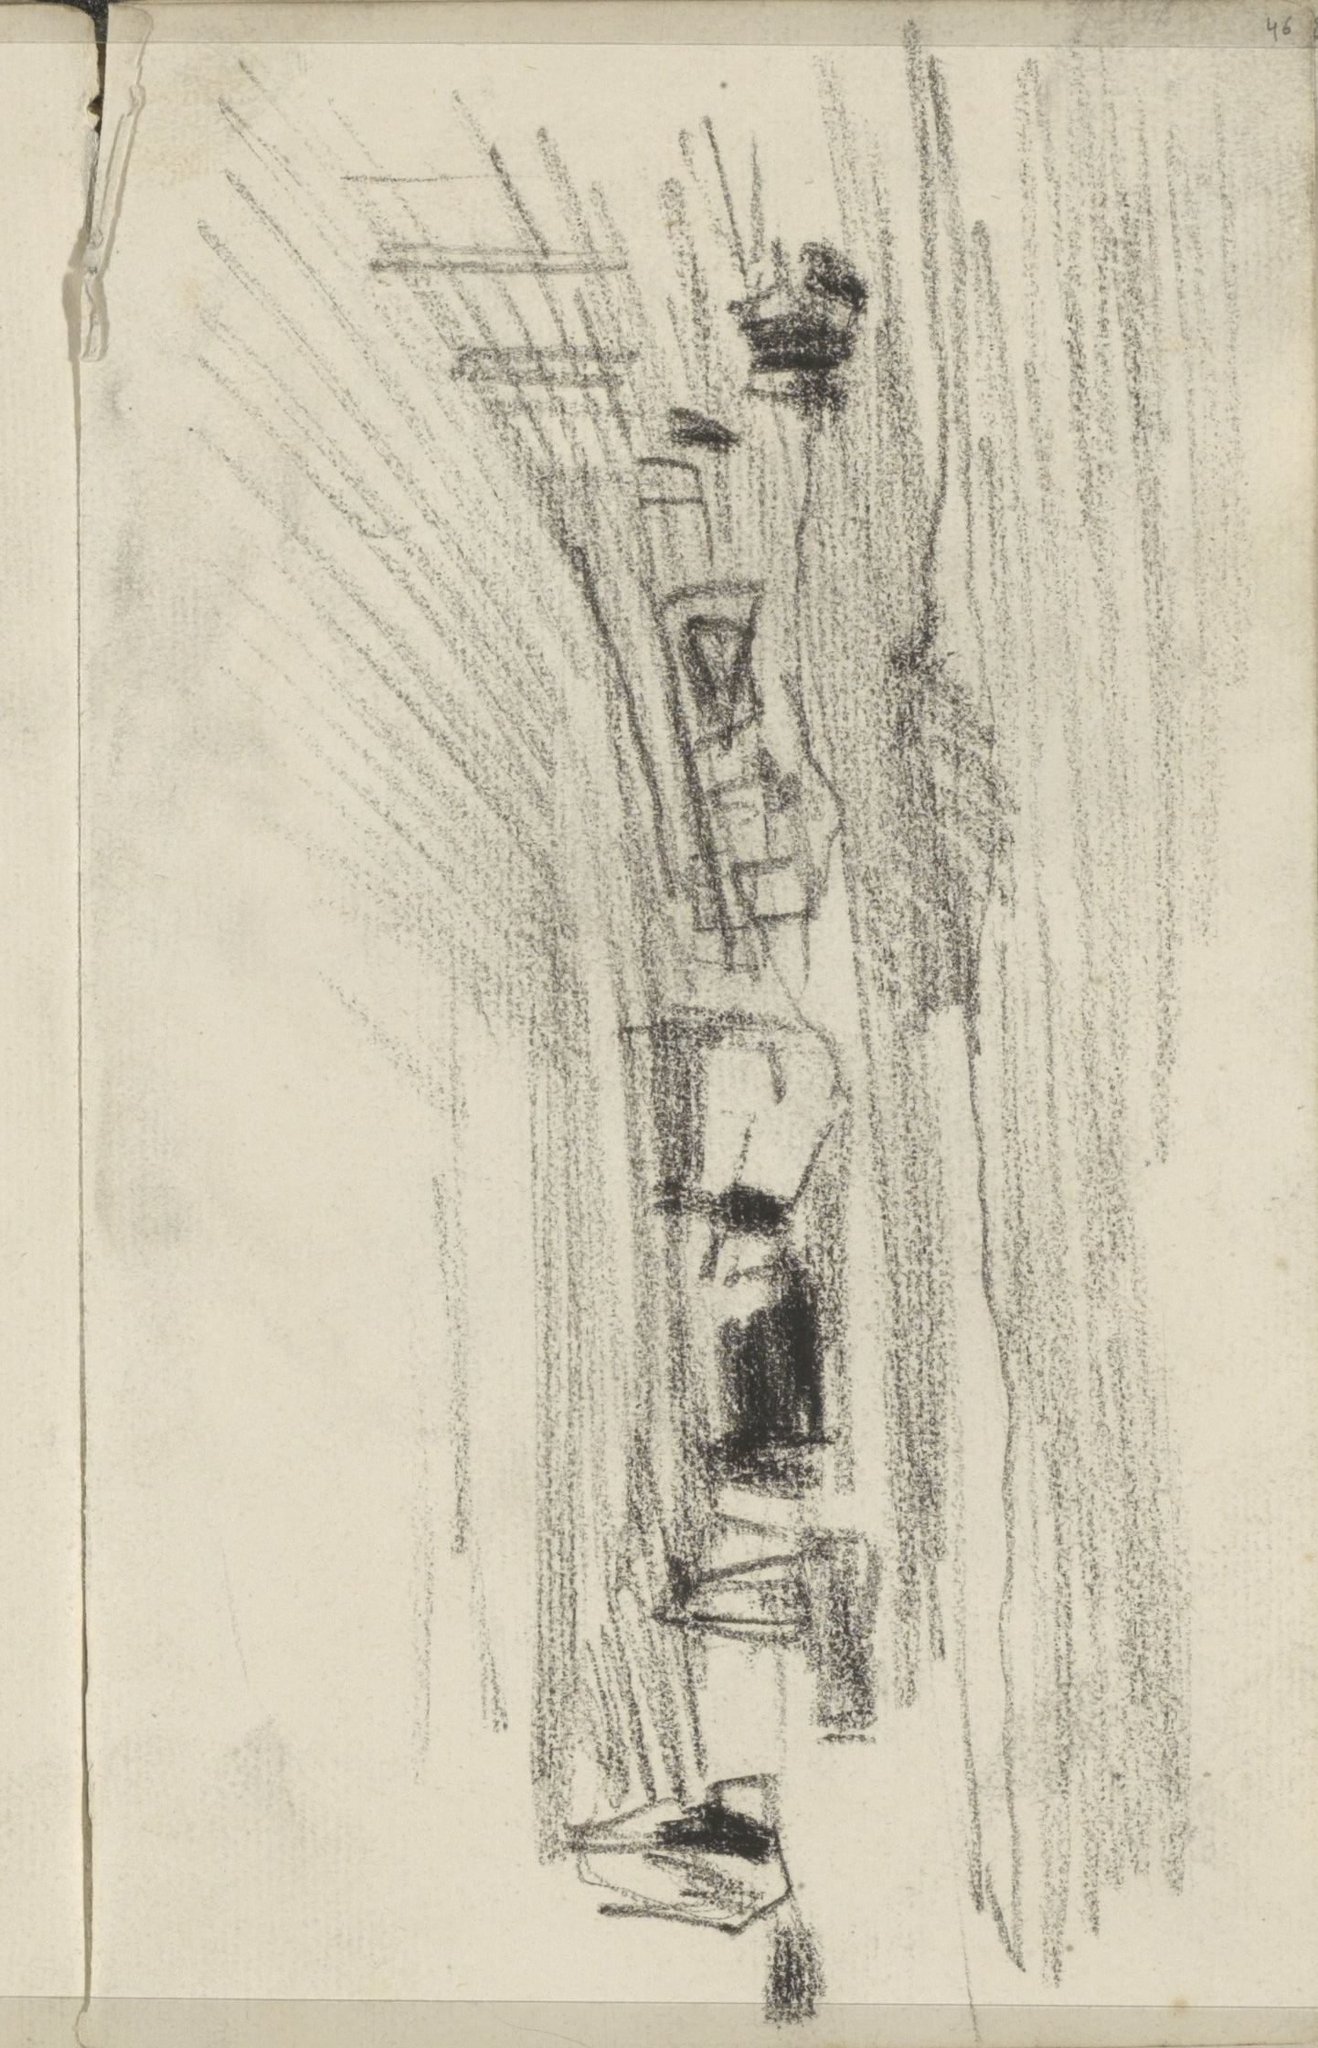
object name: sketchbook leaf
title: Koeien in een wei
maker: george hendrik breitner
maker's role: draughtsman, painter, print maker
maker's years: 1857-1923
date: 1884-1886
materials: chalk, paper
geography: the hague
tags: cow, meadow, pasture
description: Pagina 46 uit een schetsboek met 29 bladen.